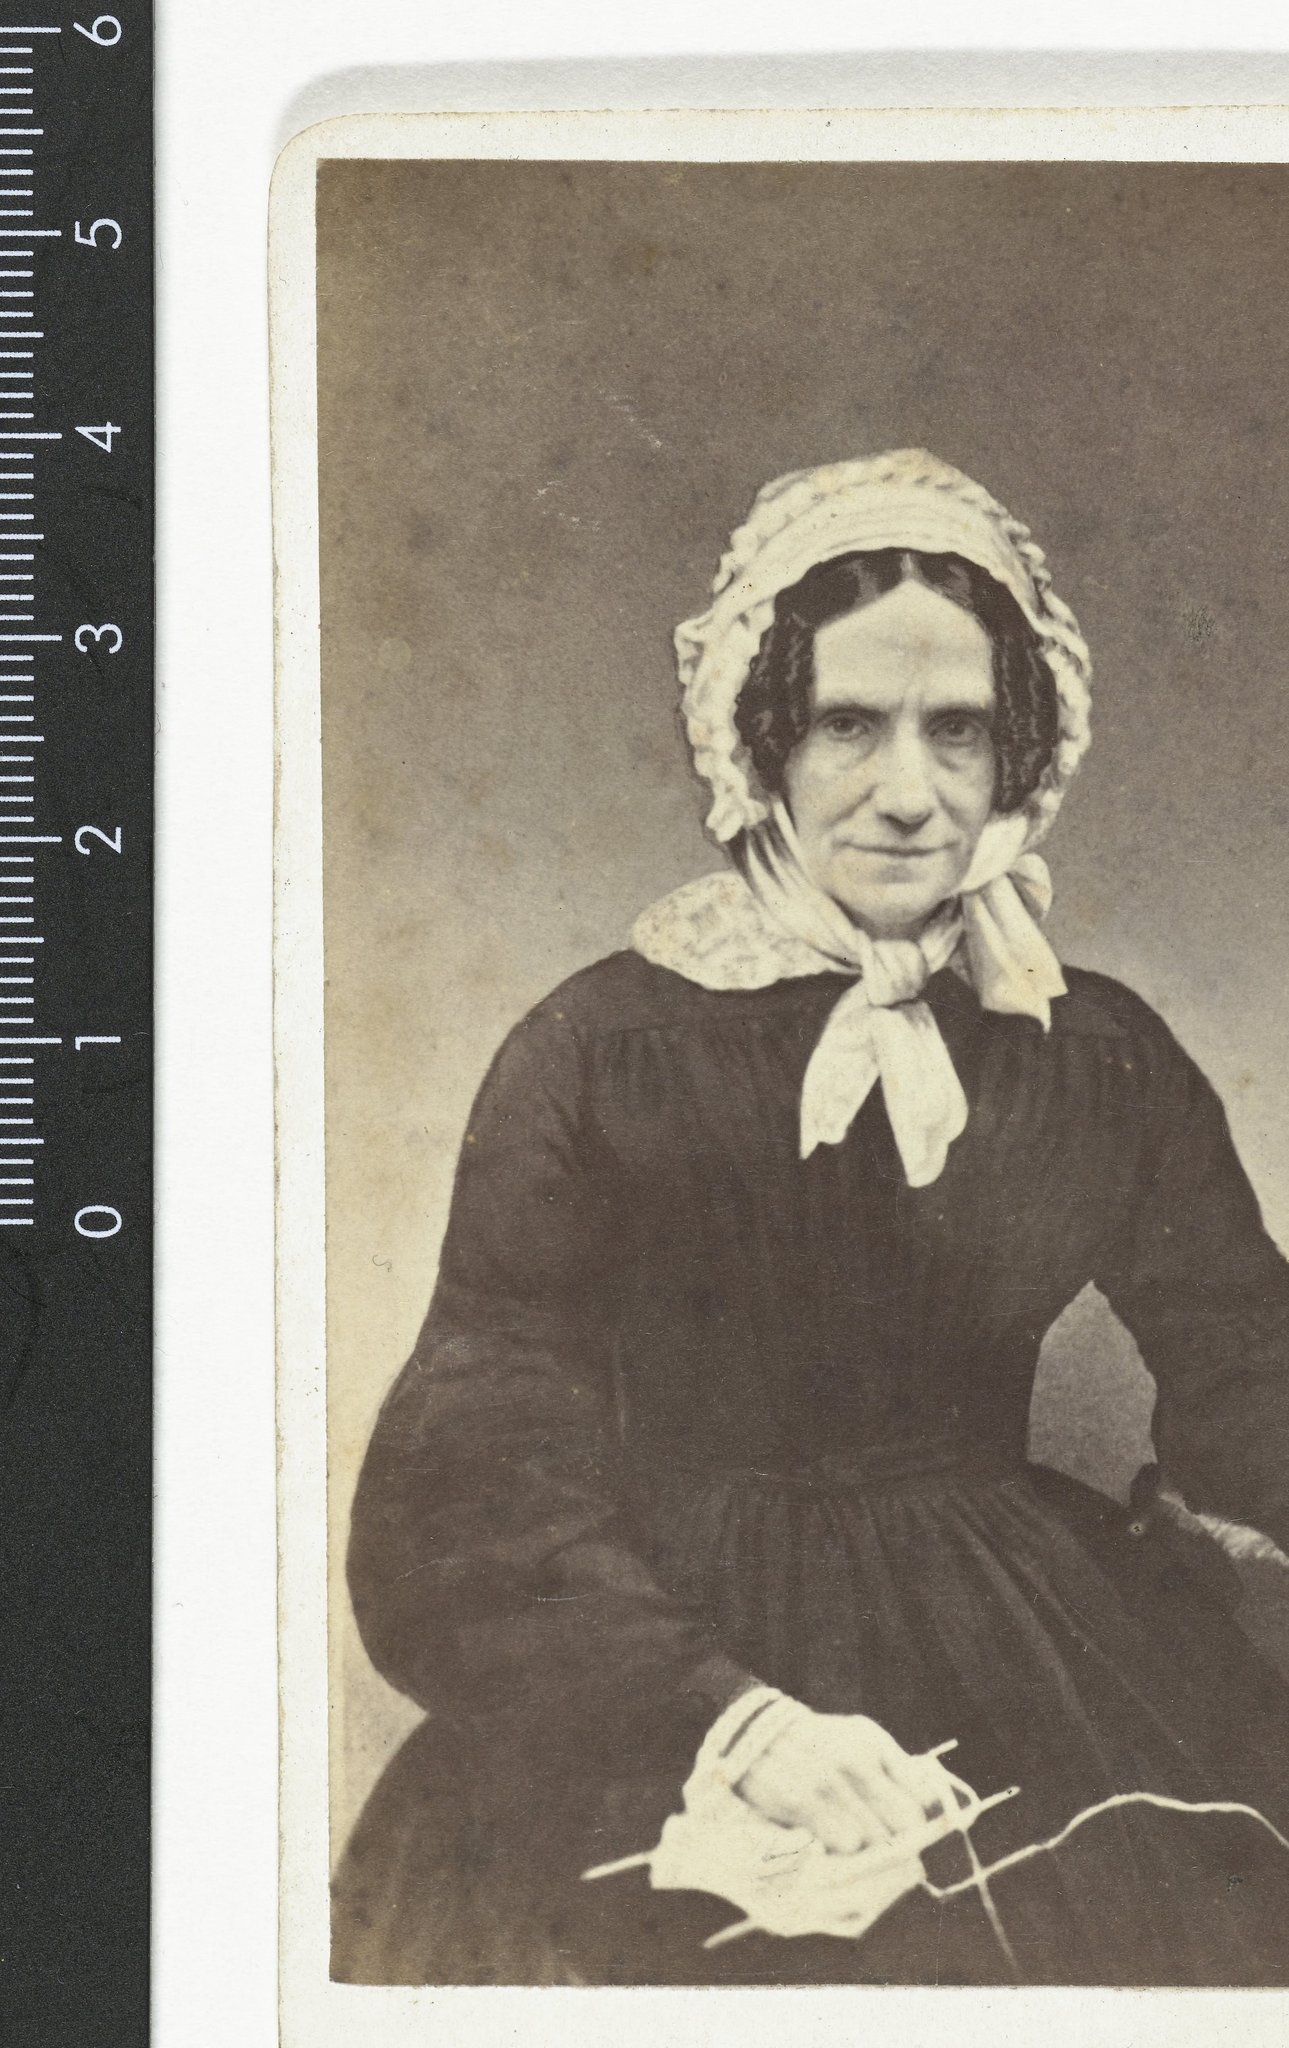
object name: photograph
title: Portret van een oudere dame met breiwerk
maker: abraham adrianus vermeulen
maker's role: painter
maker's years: 1817-1894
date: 1854-1870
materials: cardboard, paper, photographic support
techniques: albumen print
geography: utrecht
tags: historical persons not known by name - bb - woman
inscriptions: signature: ‘A.A. Vermeulen photographie Utrecht’